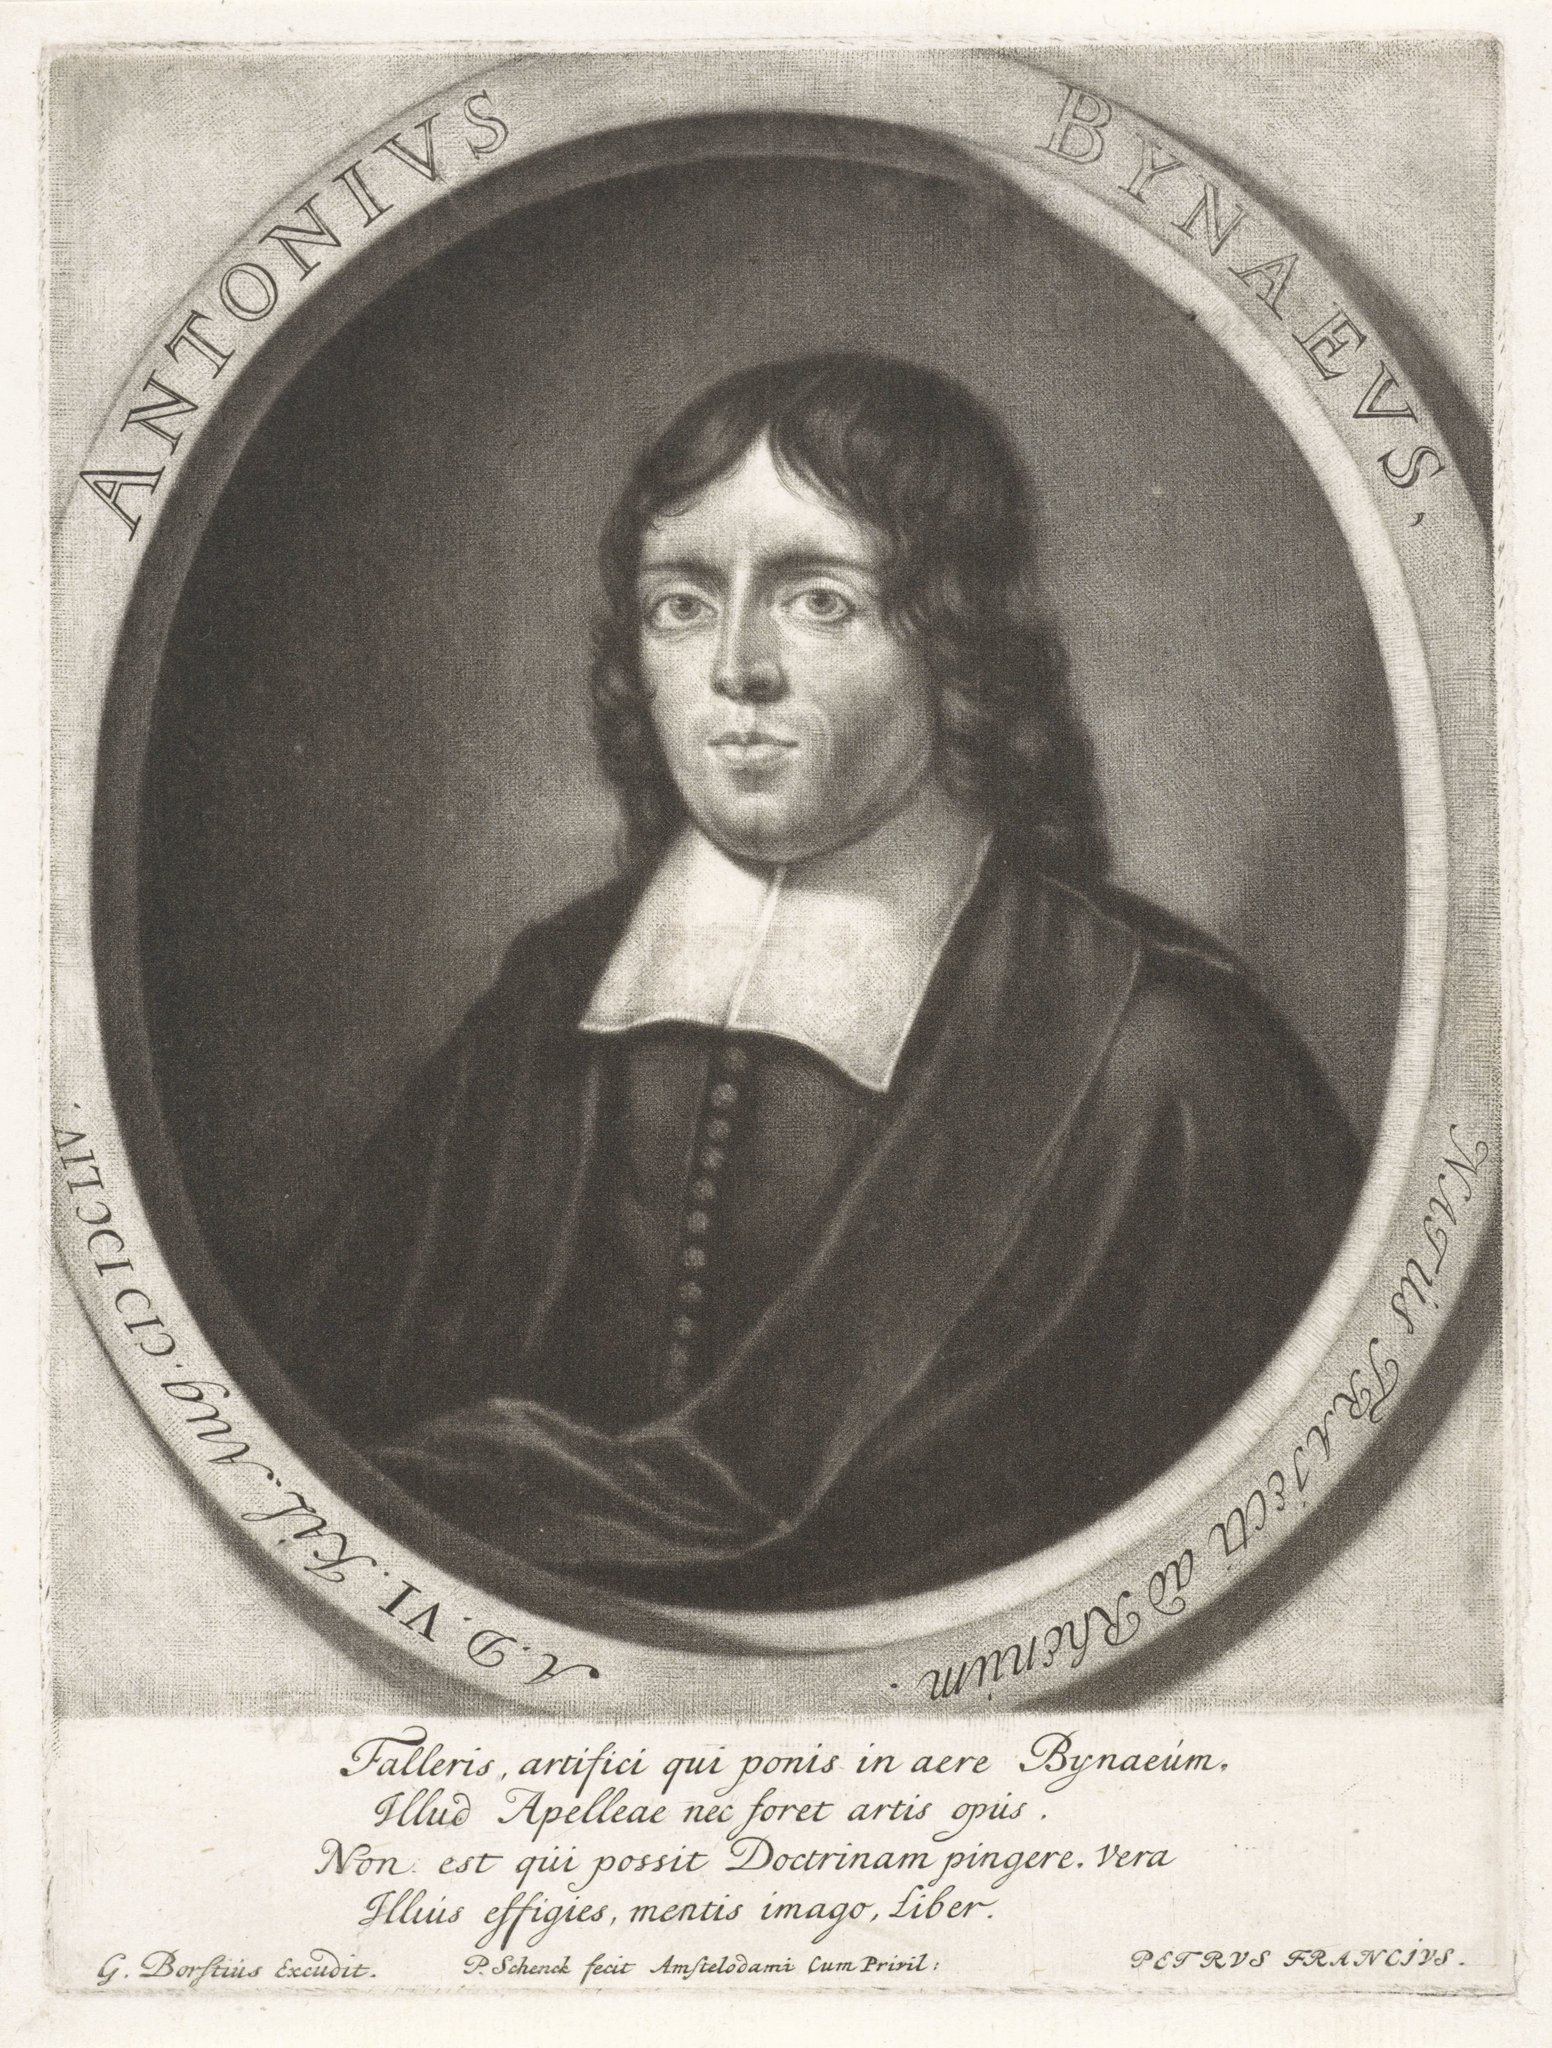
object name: print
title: Portret van de predikant Anton Bynaeus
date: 1670-1713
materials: paper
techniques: engraving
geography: amsterdam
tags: utrecht, deventer, theologian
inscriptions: collector's mark: Lugt 2228